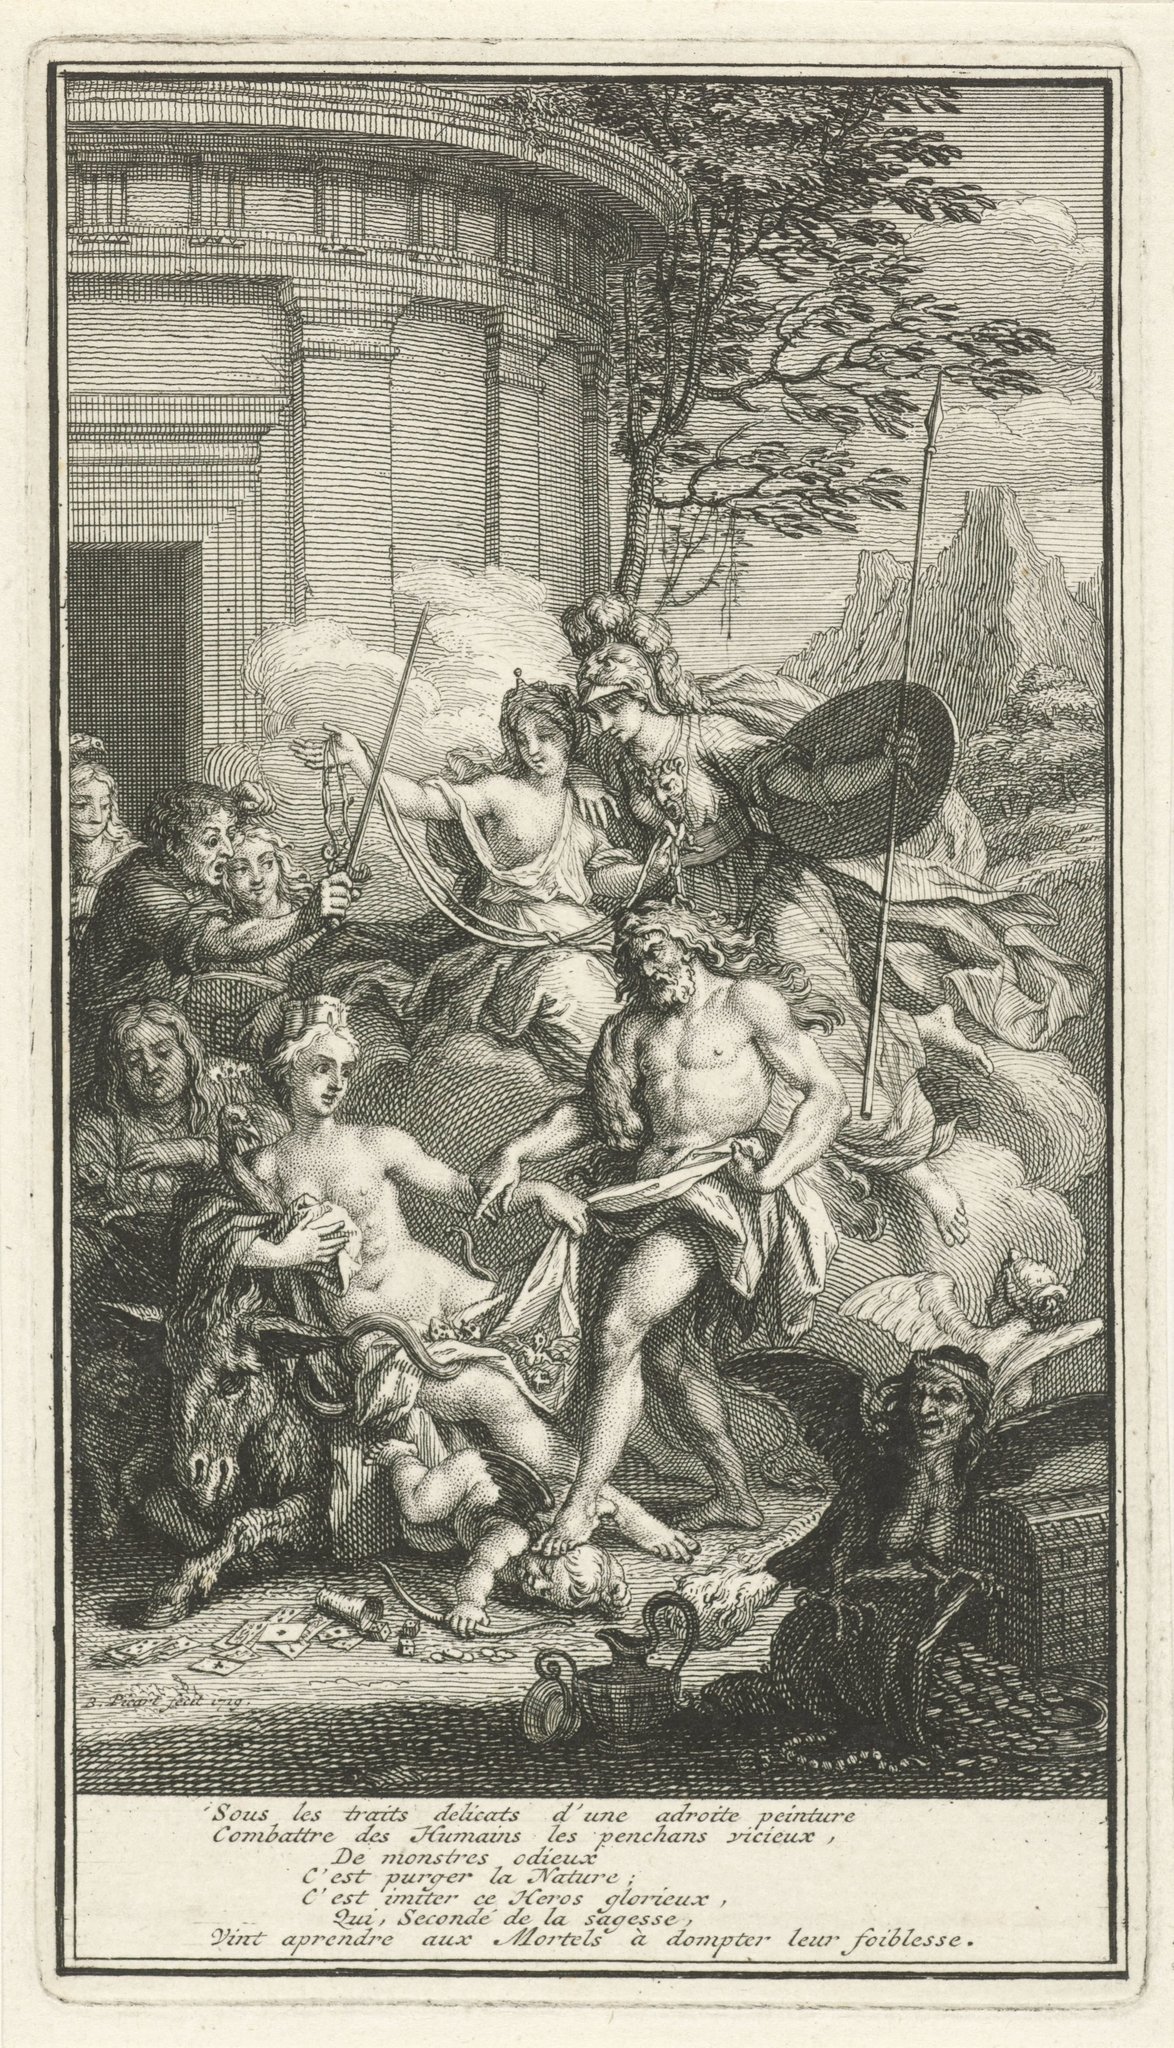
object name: titelblad, titelpagina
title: Titelpagina voor: Jean de La Bruyère, Les caracteres de Theophraste, 1731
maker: bernard picart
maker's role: draughtsman, print maker, publisher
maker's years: 1673-1733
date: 1719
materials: paper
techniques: engraving, etching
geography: amsterdam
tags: figure representing a virtue vs. a vice, temperance, 'temperantia'; 'temperanza' (ripa) ~ one of the four cardinal virtues, (story of) minerva (pallas, athena), (story of) cupid, amor (eros), hercules as personification of virtue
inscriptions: collector's mark: Lugt 240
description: De personificatie van Matigheid zit met haar paardentoom naast Minerva op een wolk. Samen proberen ze de figuren op de grond tot de orde te roepen. Links van de wolk staat een man die Matigheid en Minerva met een zwaard te lijf wil gaan. Op de voorgrond staat Hercules bij een vrouw (de Hoogmoed?): een naakte vrouw met muurkroon en met een pauw in de armen. Zij probeert hem te verleiden. Hercules trapt Amor met zijn pijl en boog tegen de grond. Op de voorgrond ligt een kaartspel en staat een gevleugeld duivels figuur op een zak met geld. In de ondermarge een zevenregelig vers in het Frans.